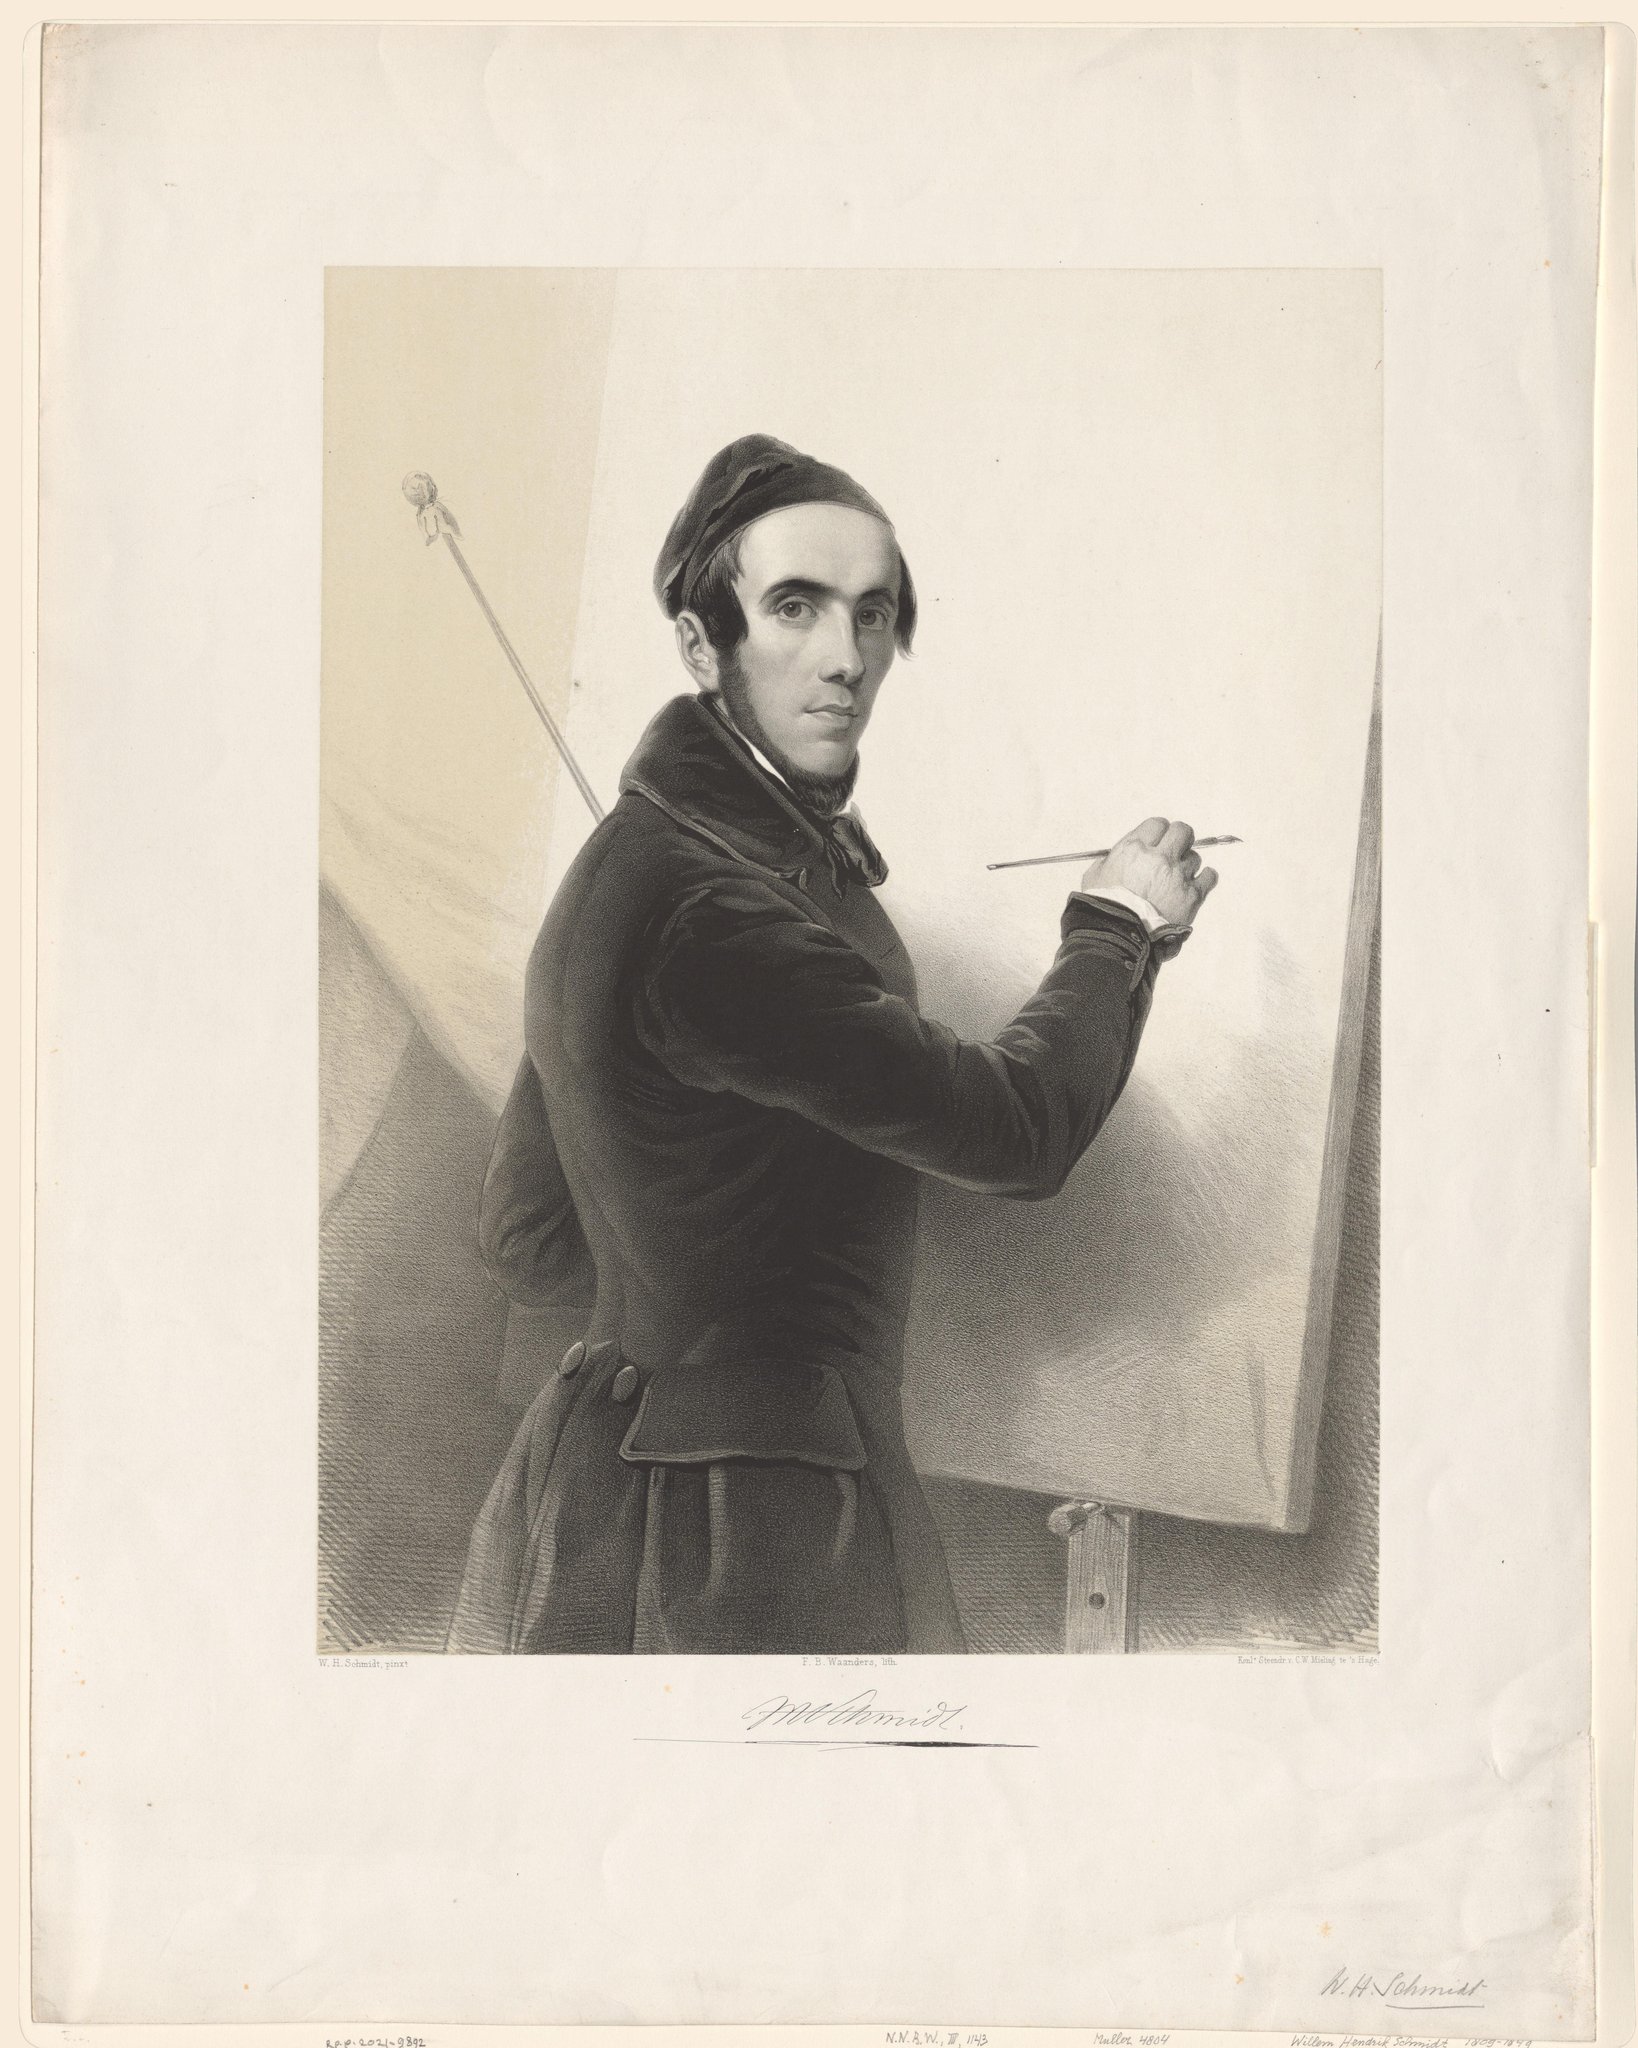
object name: print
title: Zelfportret van Willem Hendrik Schmidt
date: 1847-1853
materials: paper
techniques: tone lithography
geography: the hague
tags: rotterdam, delft, painter, print maker, draughtsman, willem hendrik schmidt, historical persons, portrait, self-portrait of painter, easel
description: De geportretteerde staat voor zijn schildersezel. Onder het portret de signatuur van de geportretteerde.